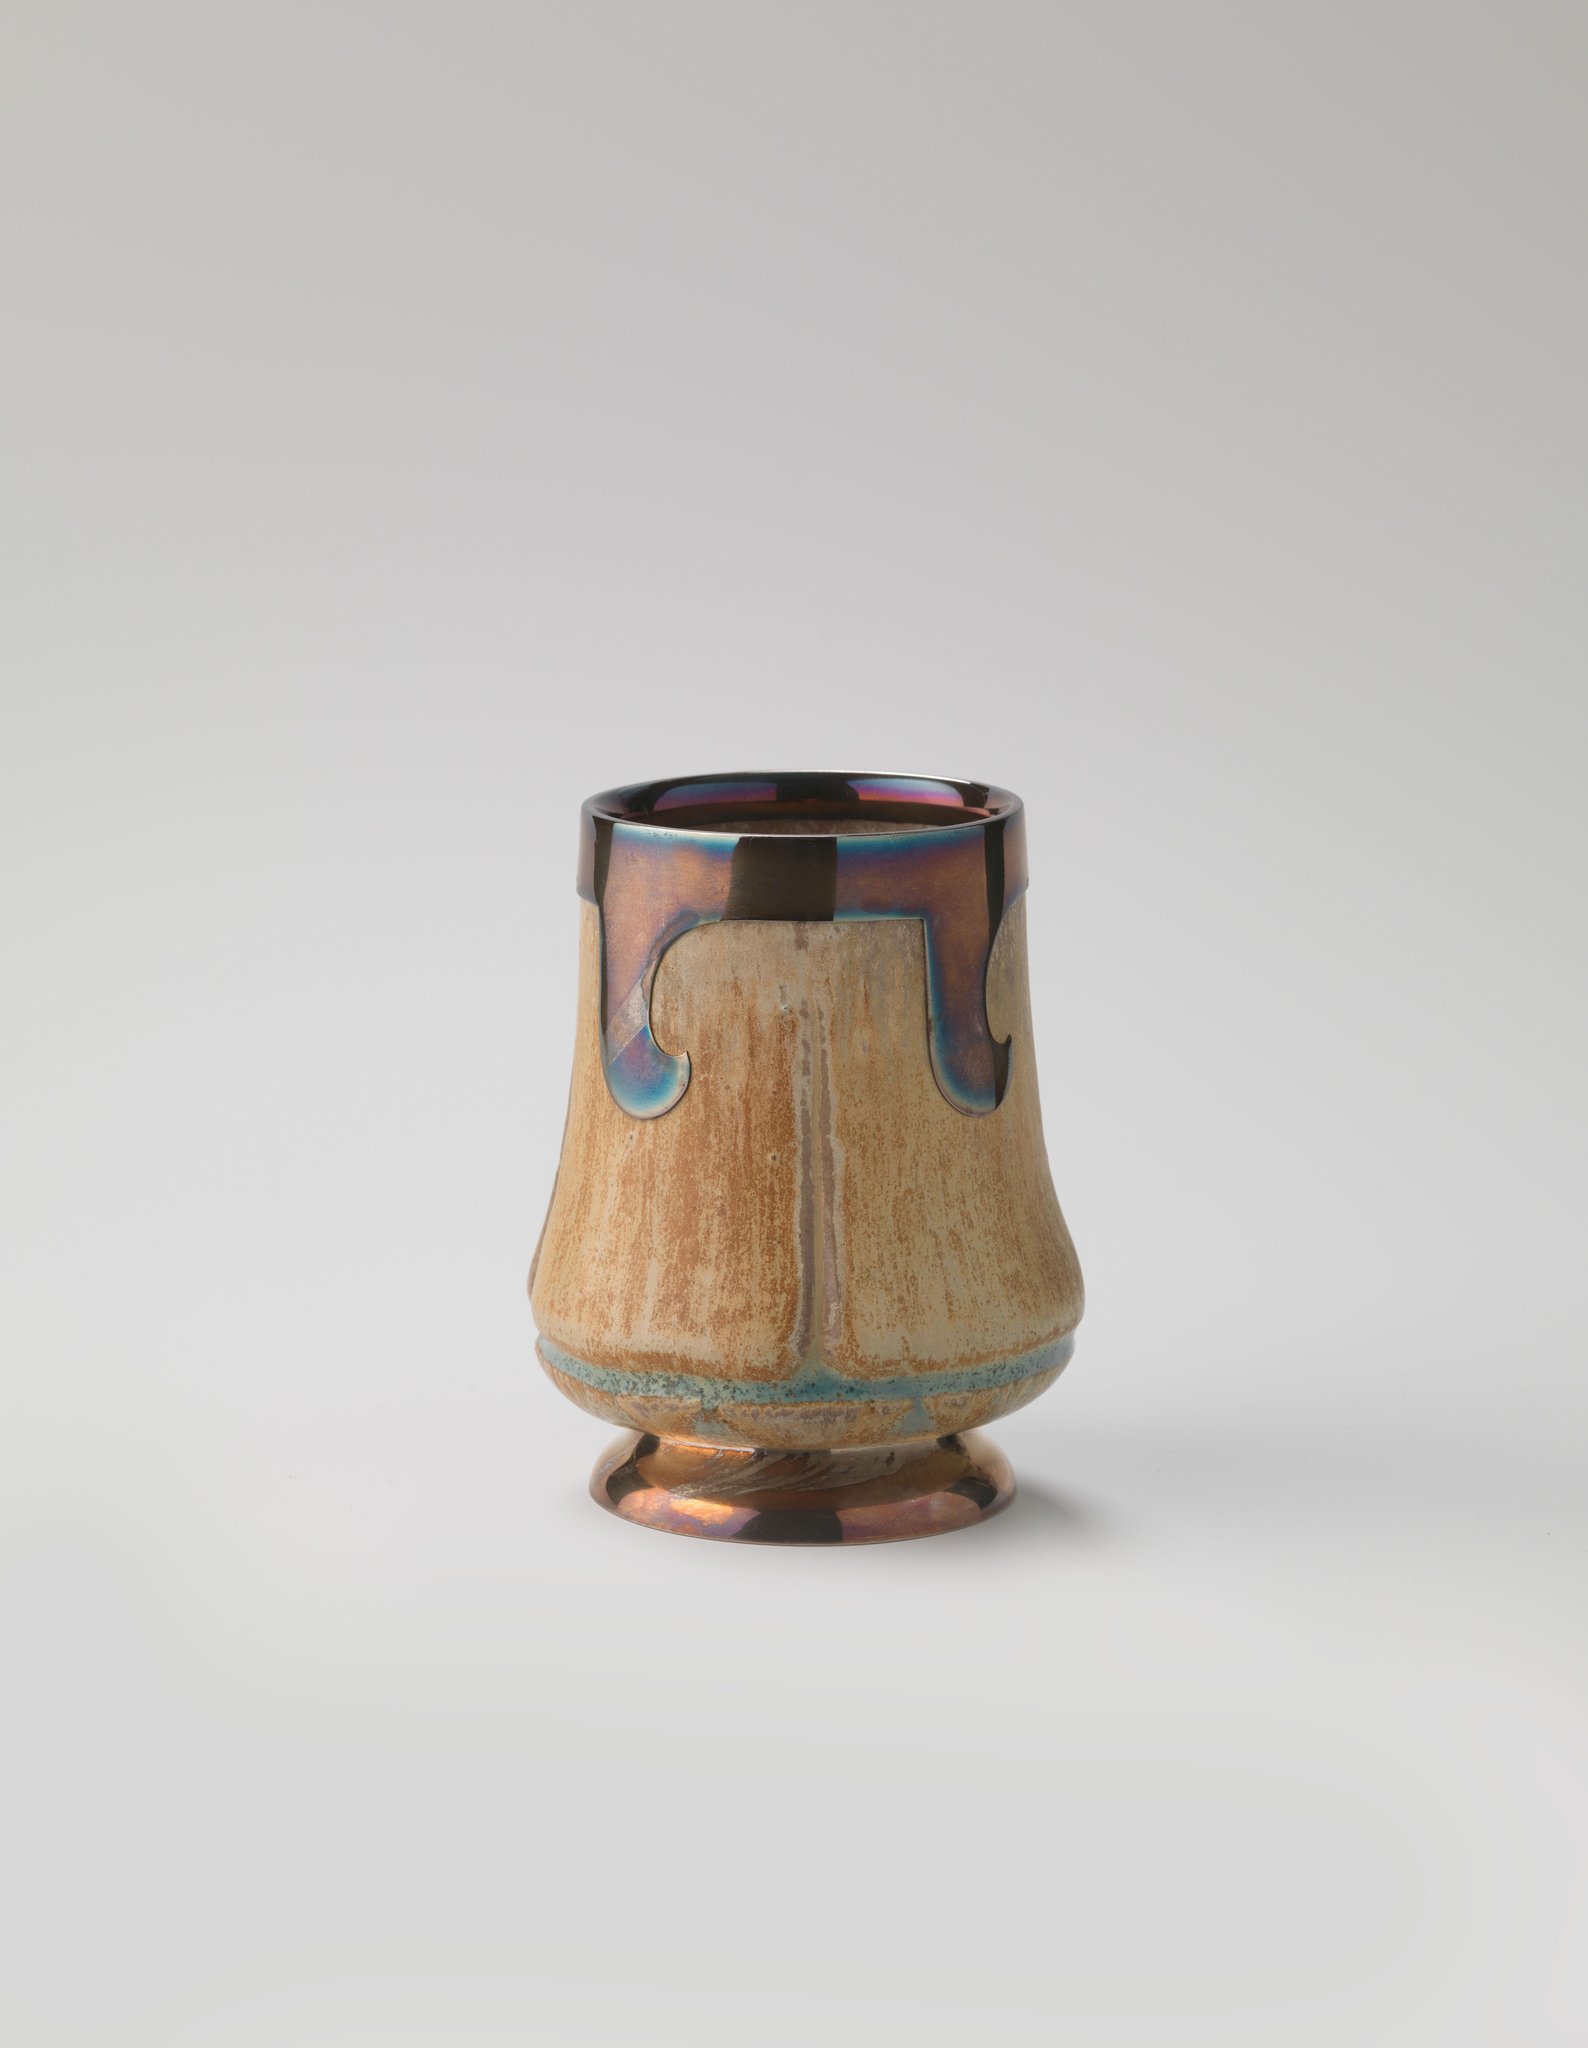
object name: cup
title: Beker van steengoed met montuur van zilver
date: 1900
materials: silver, stoneware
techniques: vitrification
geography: paris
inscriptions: inscription: ‘PIAULT LINZELER en 7060’, maker's mark: ‘RL onder kroon in een ruit’, alloy mark: ‘Minervakop met een 1’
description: Ronde beker van steengoed met montuur van zilver.